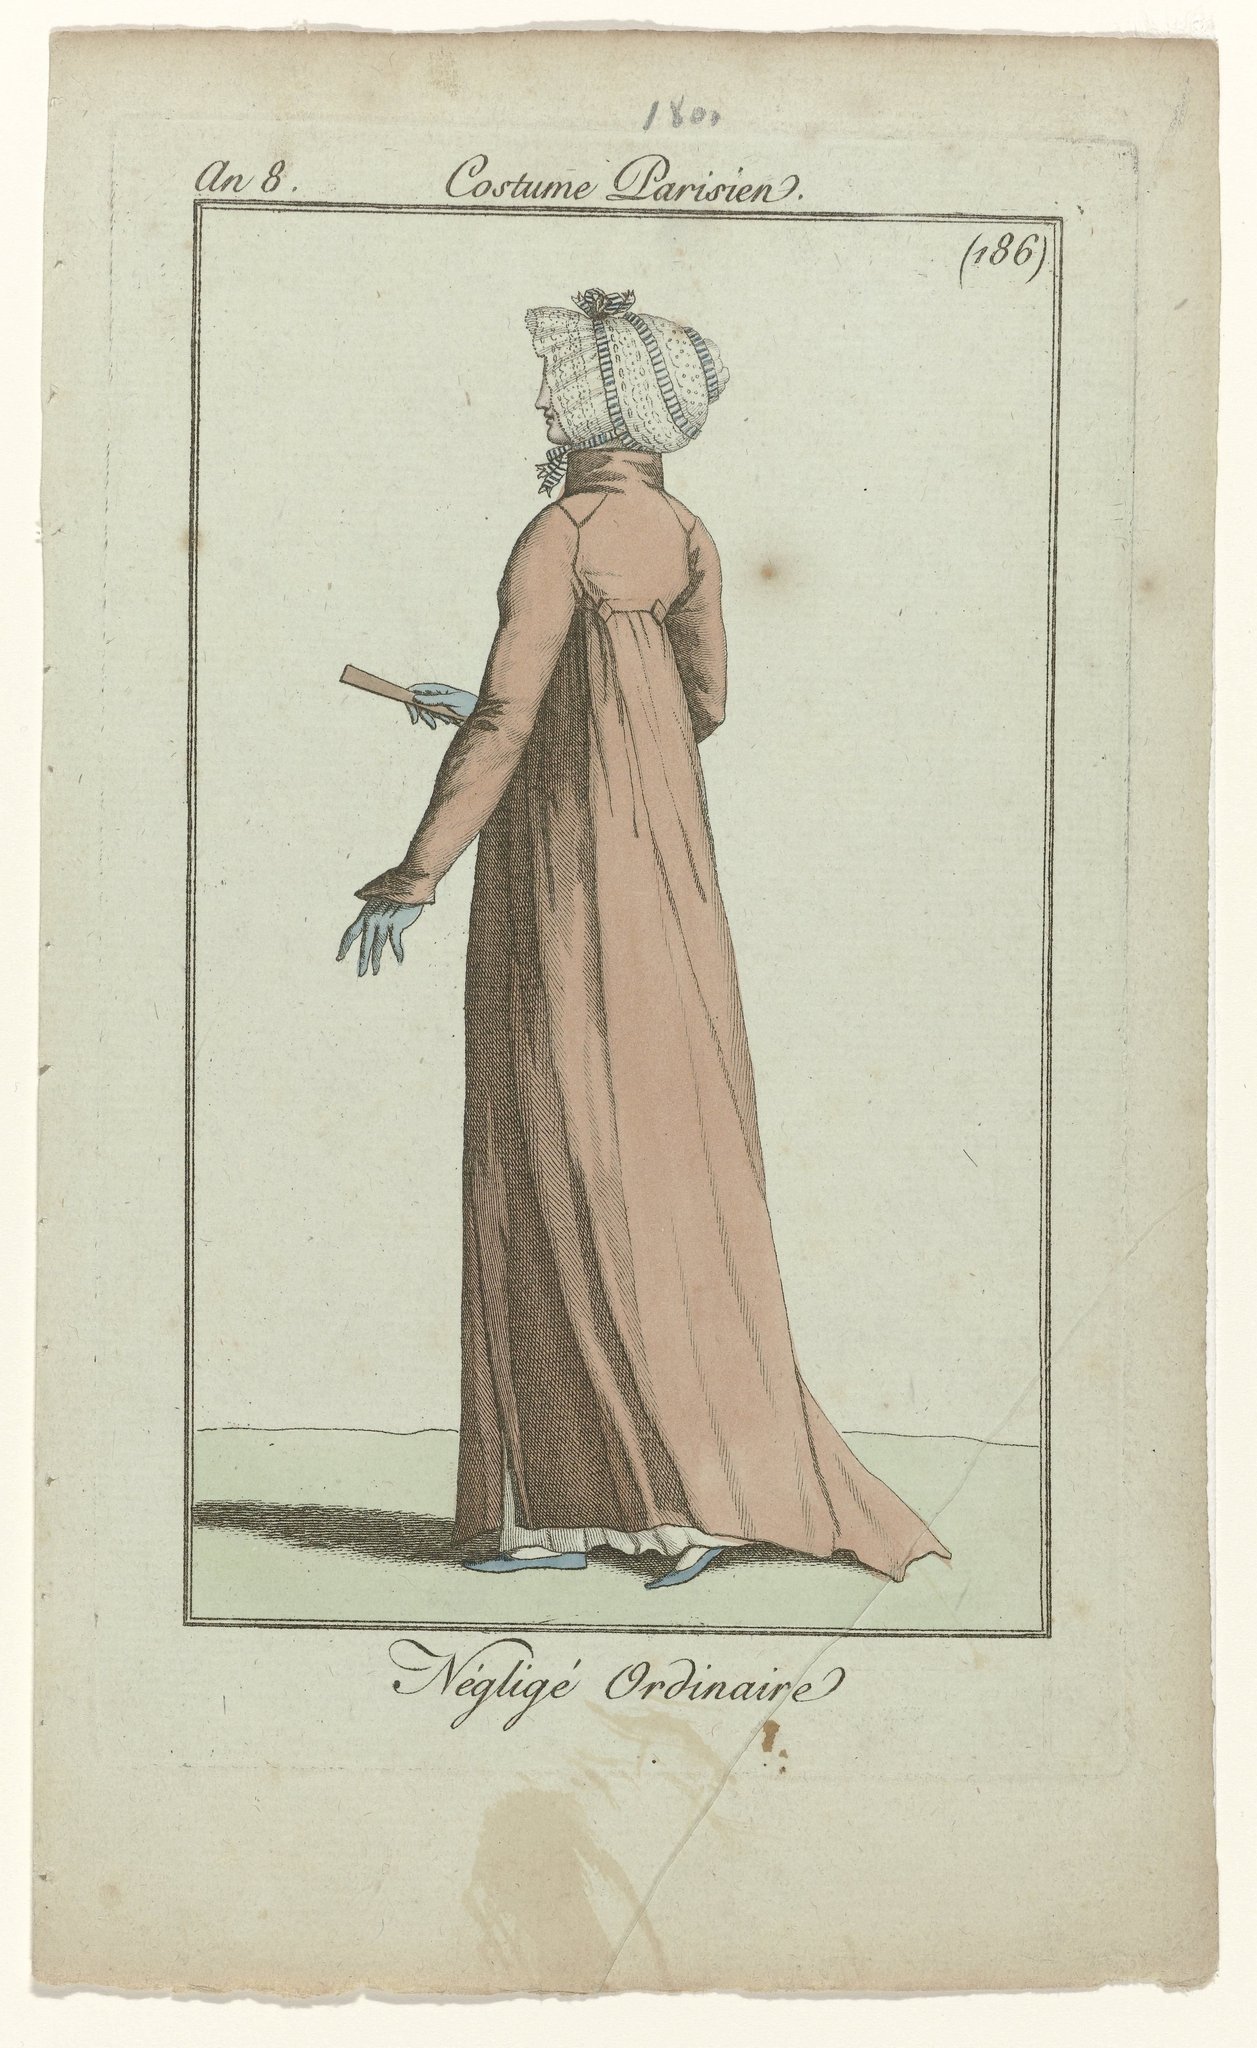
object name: fashion print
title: Journal des Dames et des Modes, Costume Parisien, 10 janvier 1800 , An 8 (186) : Négligé Ordinaire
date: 1800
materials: paper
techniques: engraving, hand coloring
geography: paris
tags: coat (+ women's clothes), head-gear: cap (+ women's clothes), fashion plates, shoes, sandals (+ women's clothes), dress, gown (+ women's clothes), fan (+ women's clothes)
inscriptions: title: ‘Costume Parisien.’, caption: ‘Négligé Ordinaire’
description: 'Négligé ordinaire'. Lange mantel (redingote?) met ruitvormige knopen en sleep. Rok(?) en kousen. Accessoires: muts met gestreept band, handschoenen, waaier, platte schoenen met puntige neuzen. De prent maakt deel uit van het modetijdschrift Journal des Dames et des Modes, uitgegeven door Pierre de la Mésangère, Parijs, 1797-1839.